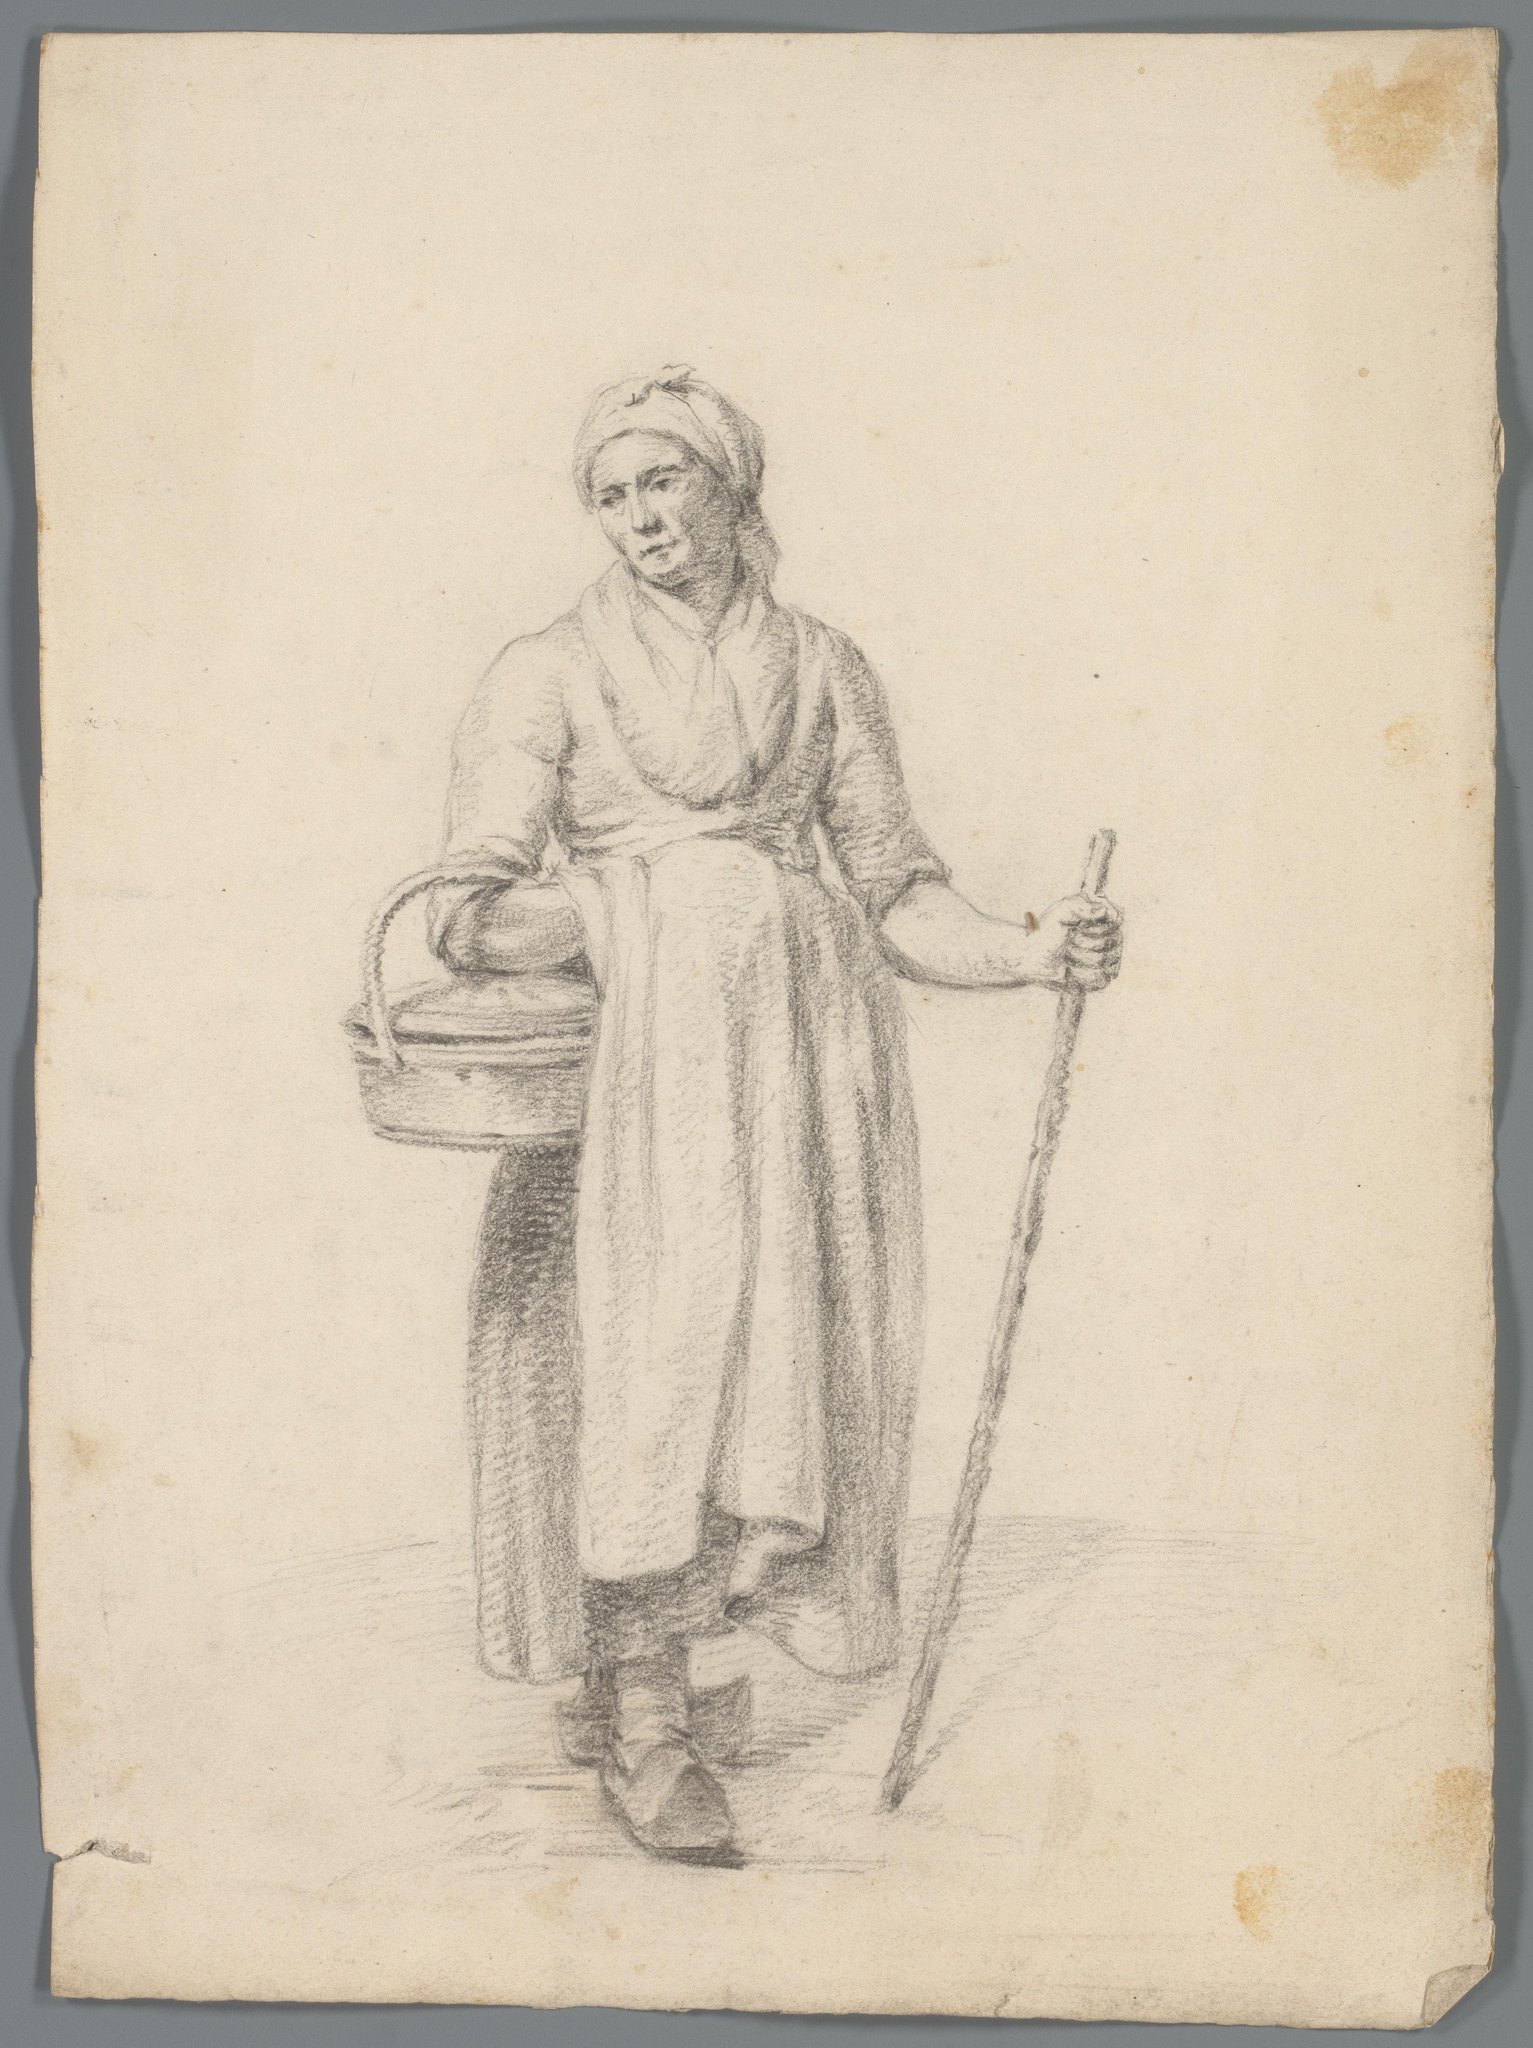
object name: drawing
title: Vrouw met een mand en stok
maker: Anonymous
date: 1820-1830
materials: chalk, paper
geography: the hague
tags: adult woman, walking-stick, staff, wooden shoes, clogs, container made of plant material other than wood: basket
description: Tekeningen waarschijnlijk ontstaan bij het Haagse kunstgenootschap ‘Tot Nut der Tekenkunst’, waar twee keer per week tekenavonden werden georganiseerd met geklede modellen.